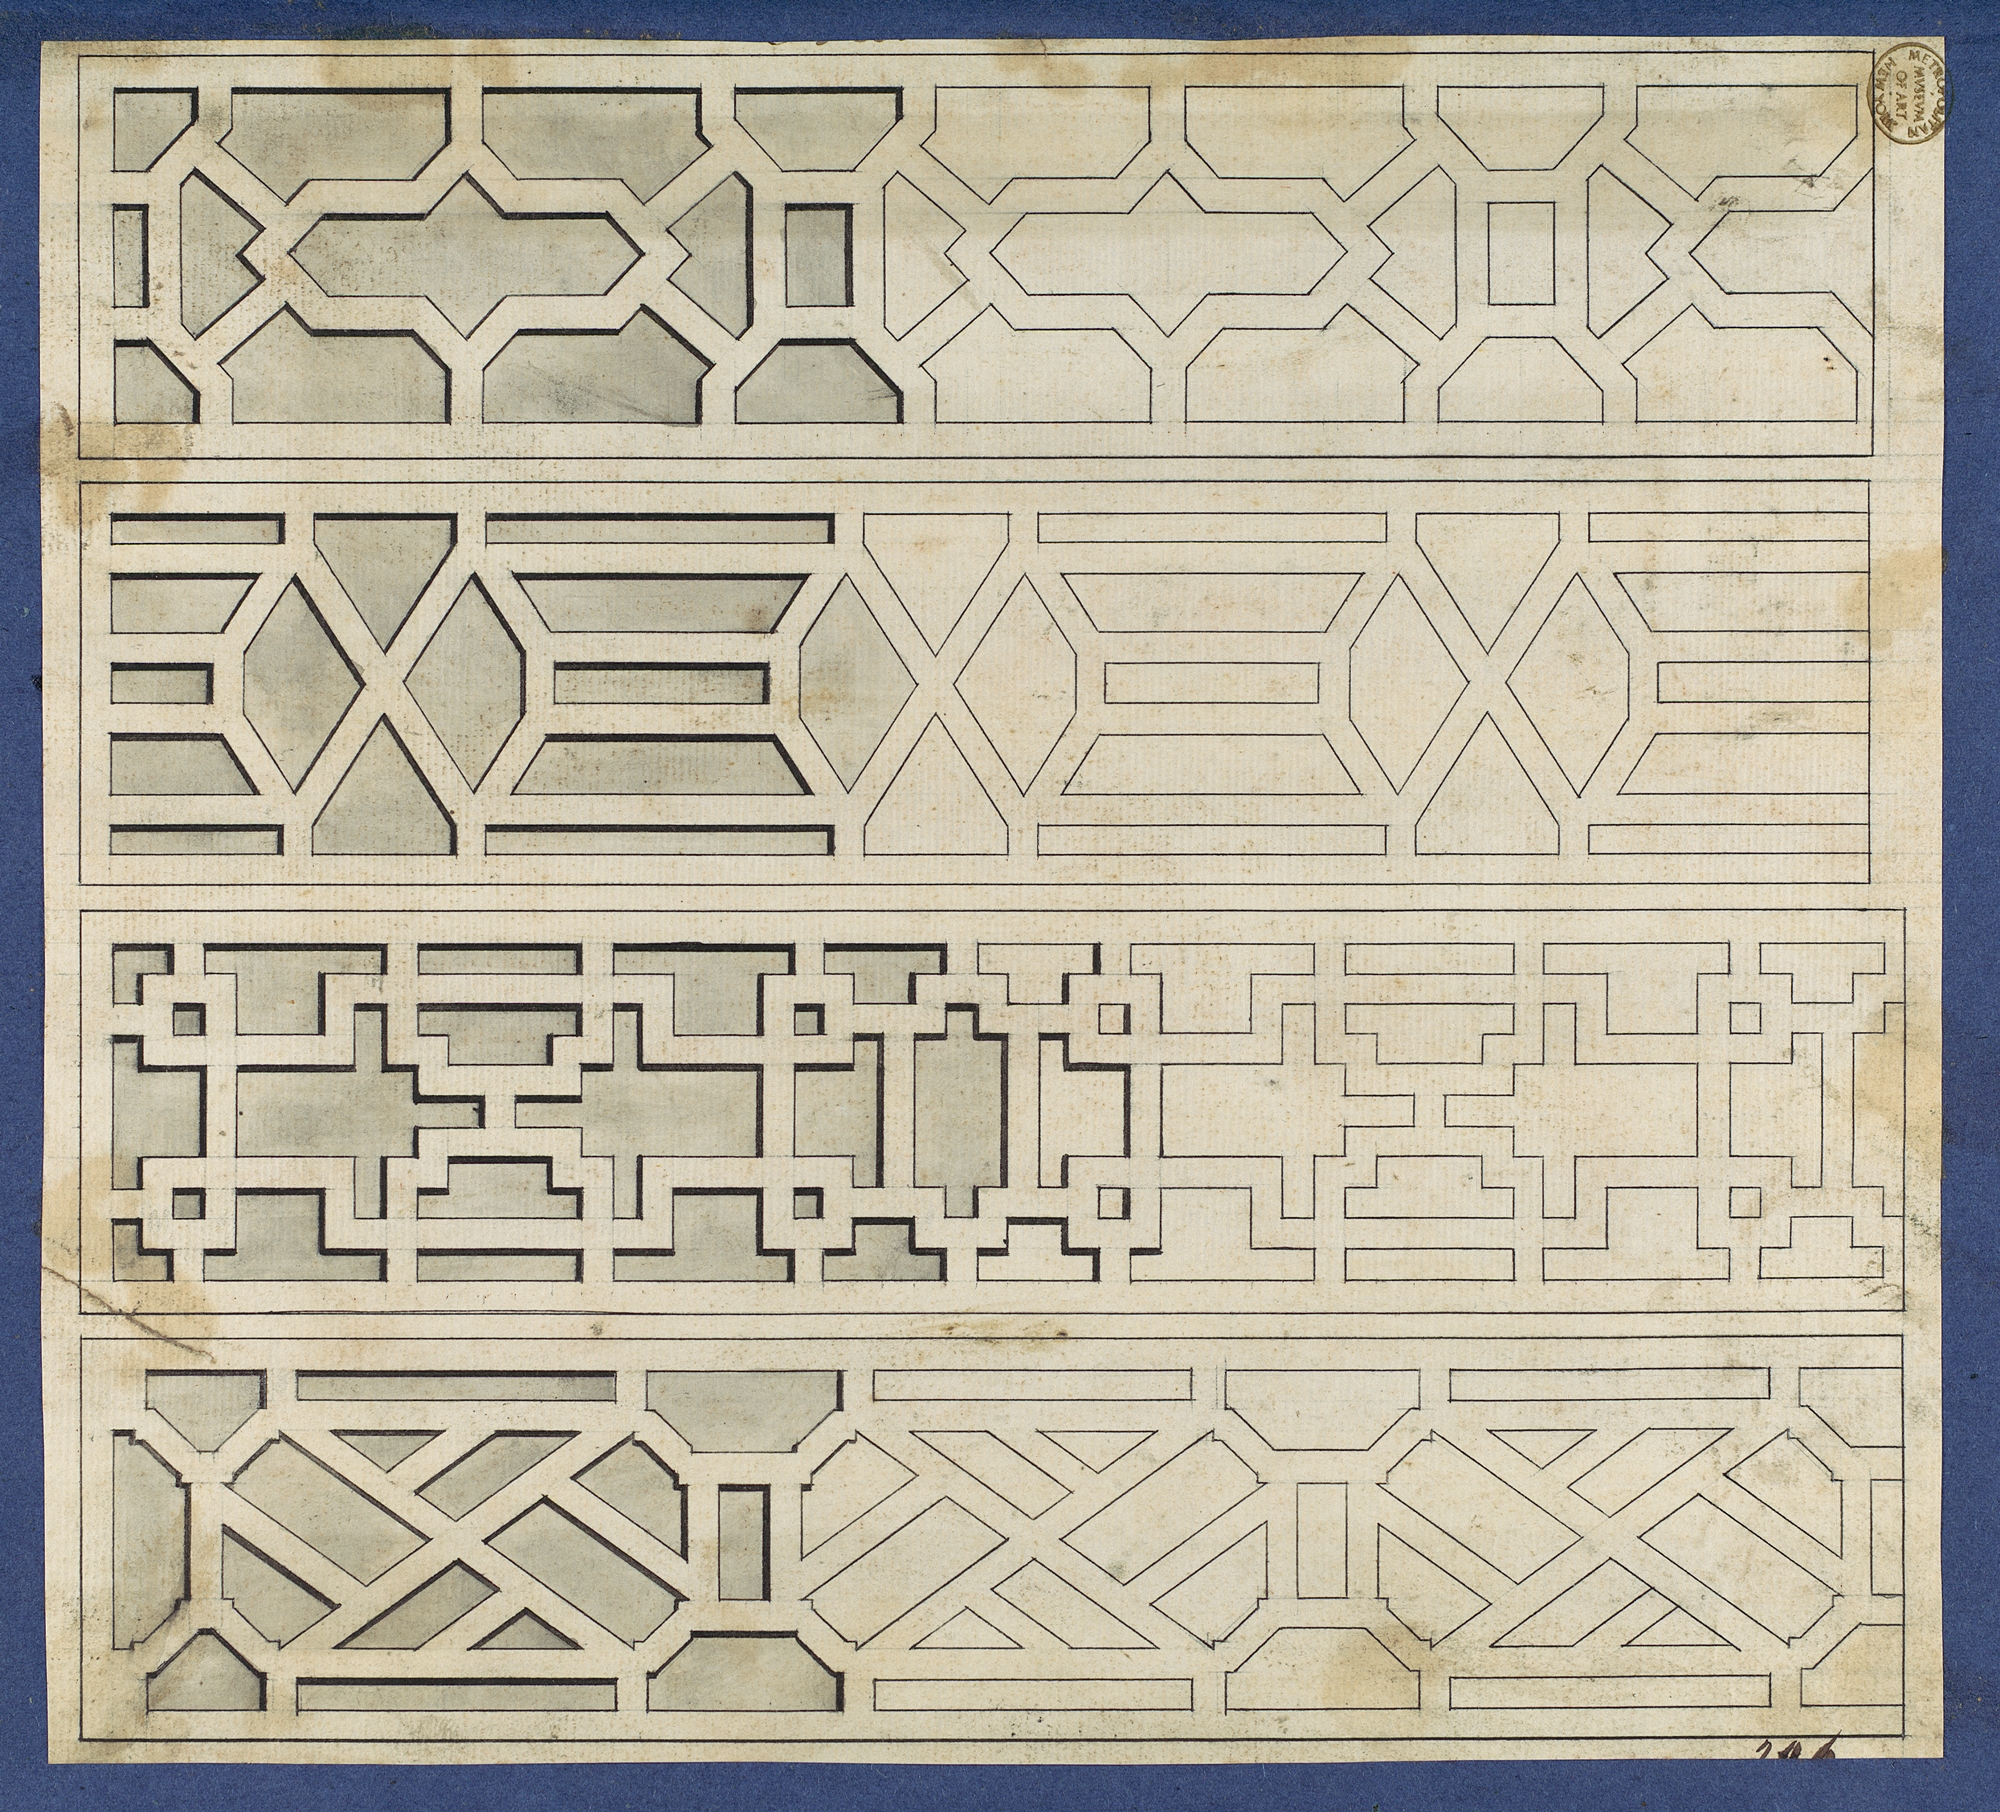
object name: drawing ornament architecture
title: Frets, from Chippendale Drawings, Vol. II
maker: thomas chippendale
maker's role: artist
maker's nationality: british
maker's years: 1718-1779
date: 1754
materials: ink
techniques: wash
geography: london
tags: ornament